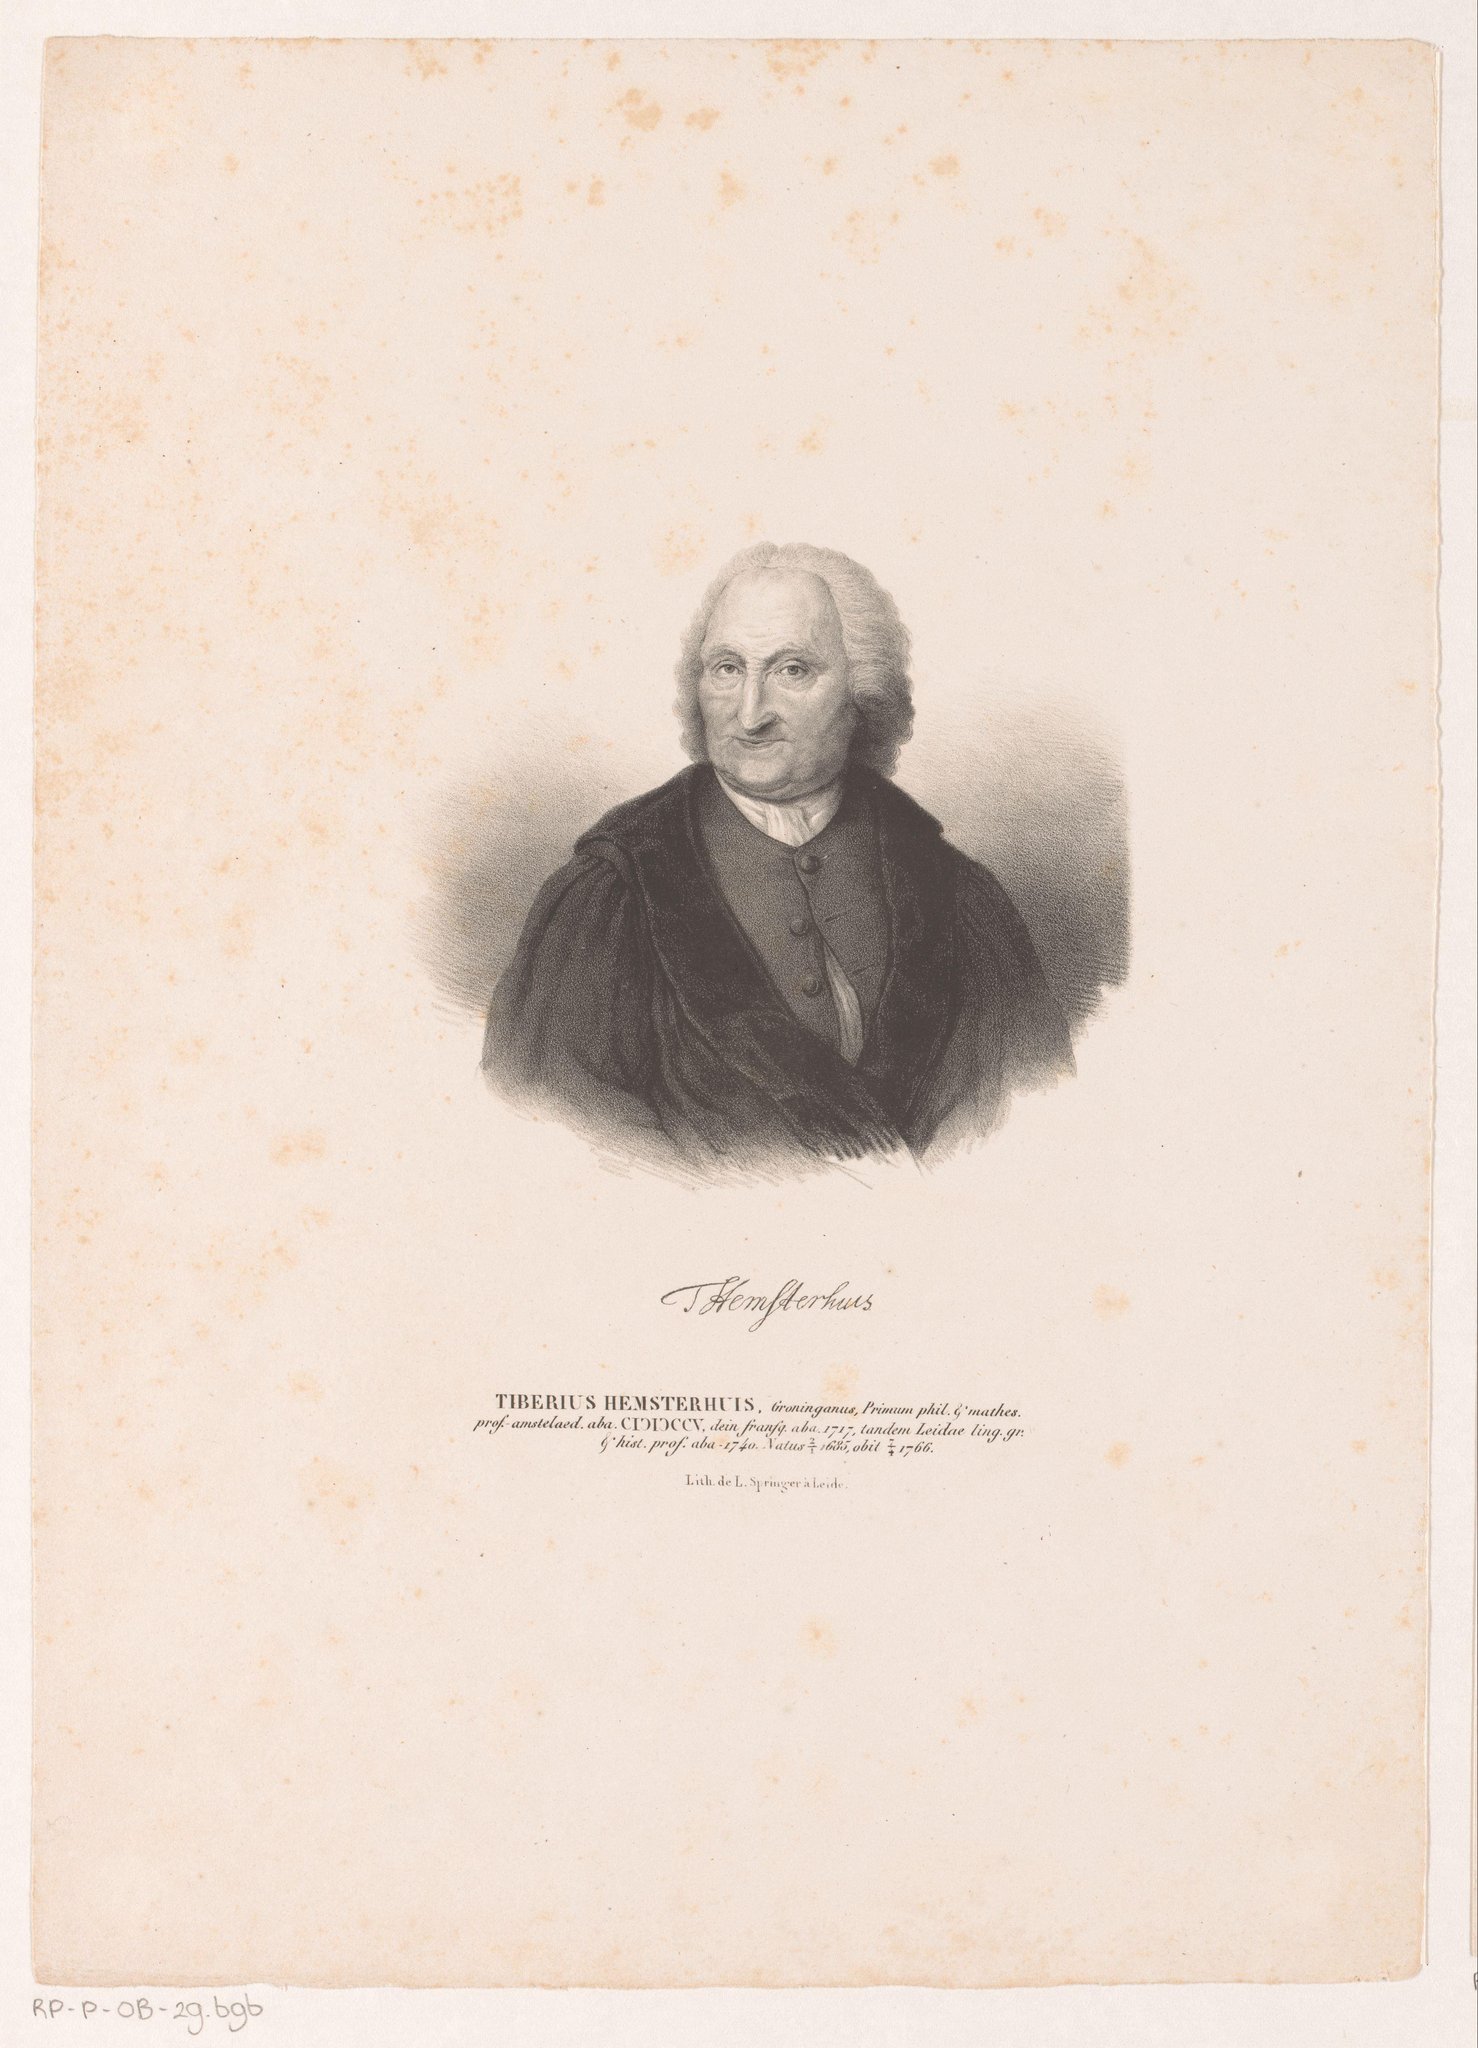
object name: print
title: Portret van Tiberius Hemsterhuis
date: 1809-1871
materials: paper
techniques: lithograph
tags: historical persons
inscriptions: collector's mark: Lugt 2228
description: Onder het portret de signatuur en biografische gegevens van de geportretteerde.